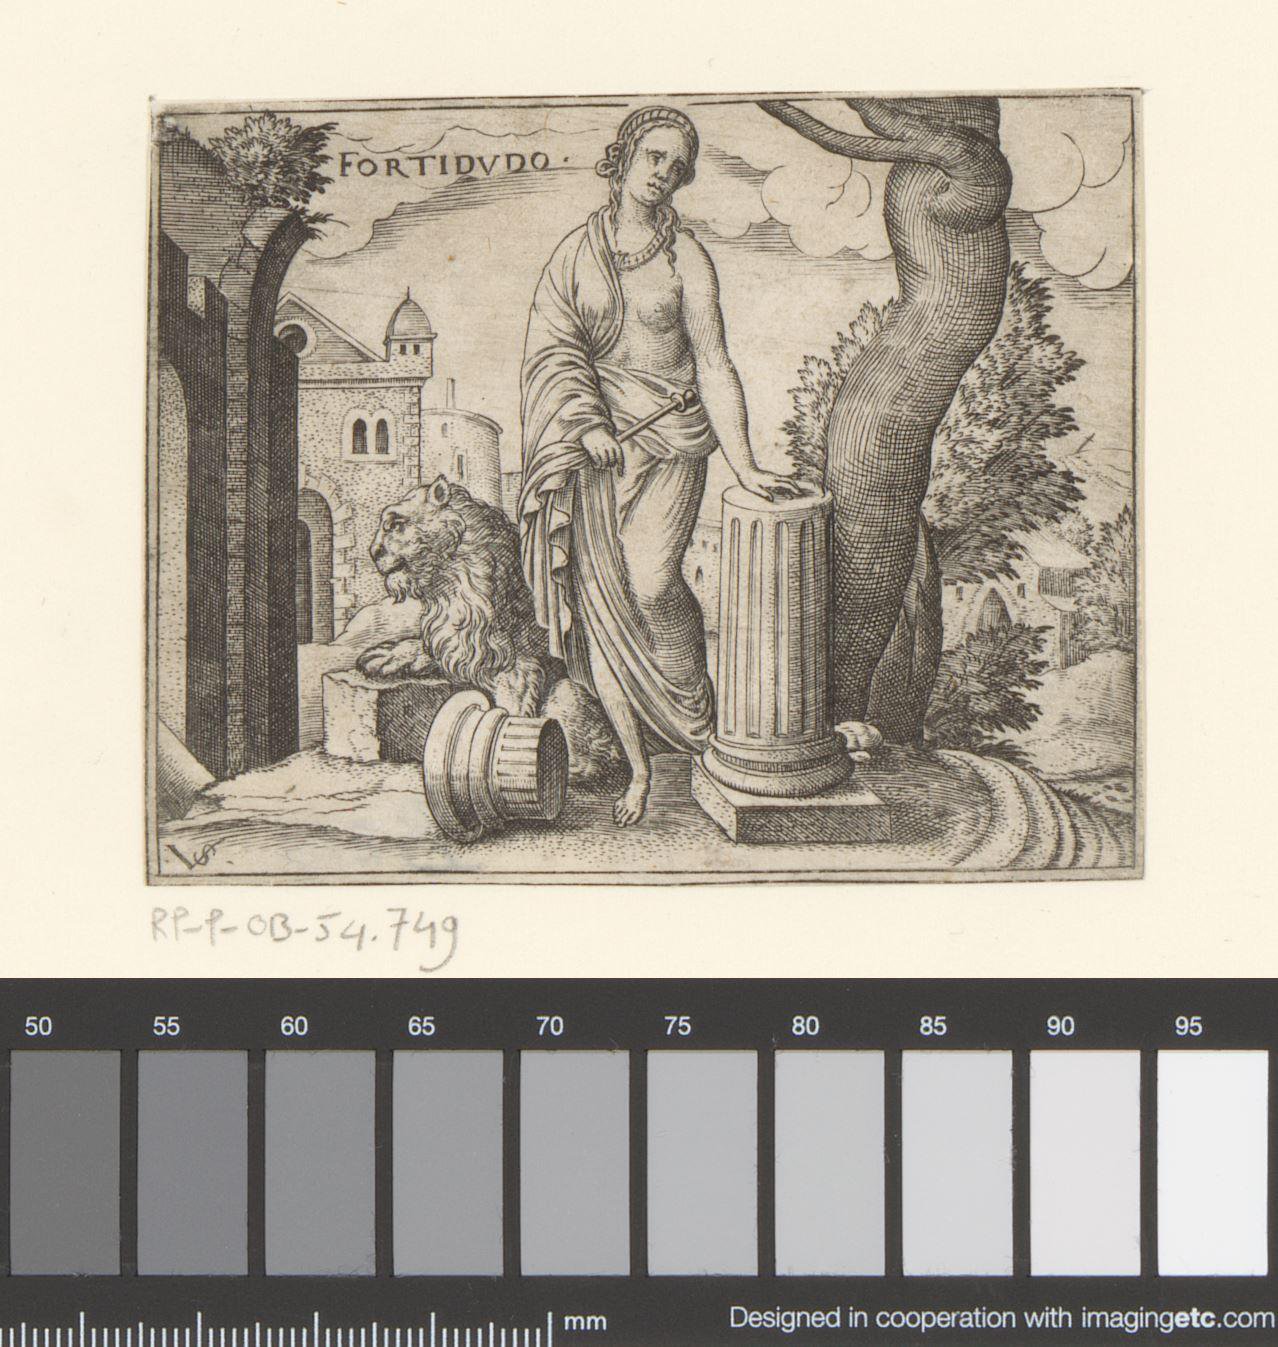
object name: print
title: Kracht (Fortitudo)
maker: virgilius solis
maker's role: draughtsman, print maker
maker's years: 1514-1562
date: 1524-1562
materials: paper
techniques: engraving, etching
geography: nuremberg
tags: fortitude, 'fortitudo' ~ one of the four cardinal virtues, city-view, and landscape with man-made constructions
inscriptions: number: ‘60’, collector's mark: Lugt 2228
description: Prent maakt deel uit van een serie van acht prenten met personificaties van deugden staand in landschappen.